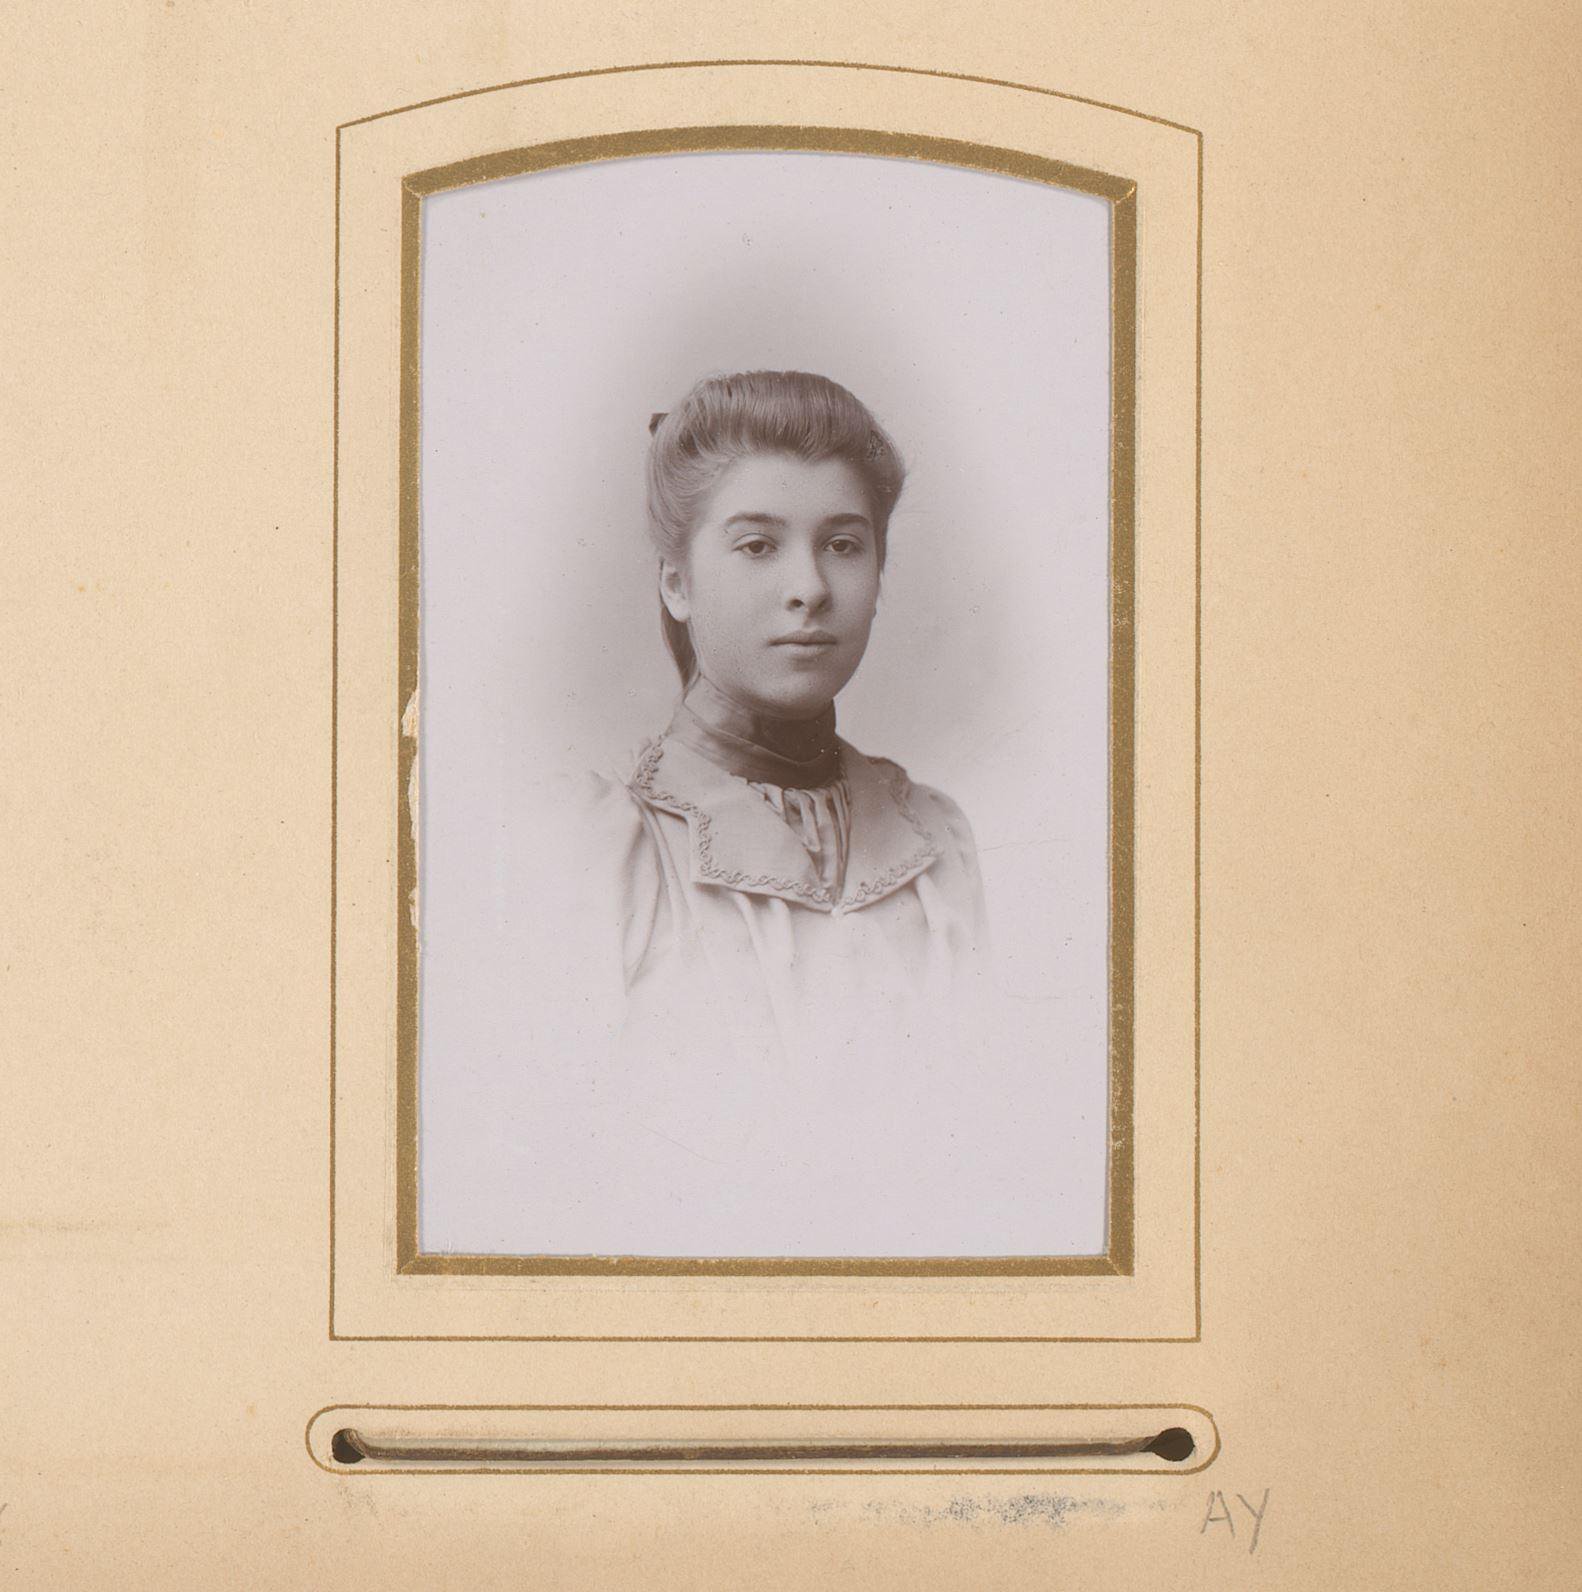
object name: carte de visite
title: Portret van een jonge vrouw, aangeduid als Wanda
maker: conrad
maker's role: fotograaf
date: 1880-1920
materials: cardboard, photographic support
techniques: collodion silver print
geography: warsaw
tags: adolescent, young woman, maiden, historical persons - bb - woman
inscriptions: inscription: ‘Fotografija/ Artystyczna/ Conrad/ w Warszawie/ ULICA ERYWANSKA PLAC ZIELONY No 14.’, annotation: ‘Meiner lieben Agnes/ zur [freundlichen] Erinn./ [...] an ihre[.]/ Wanda’